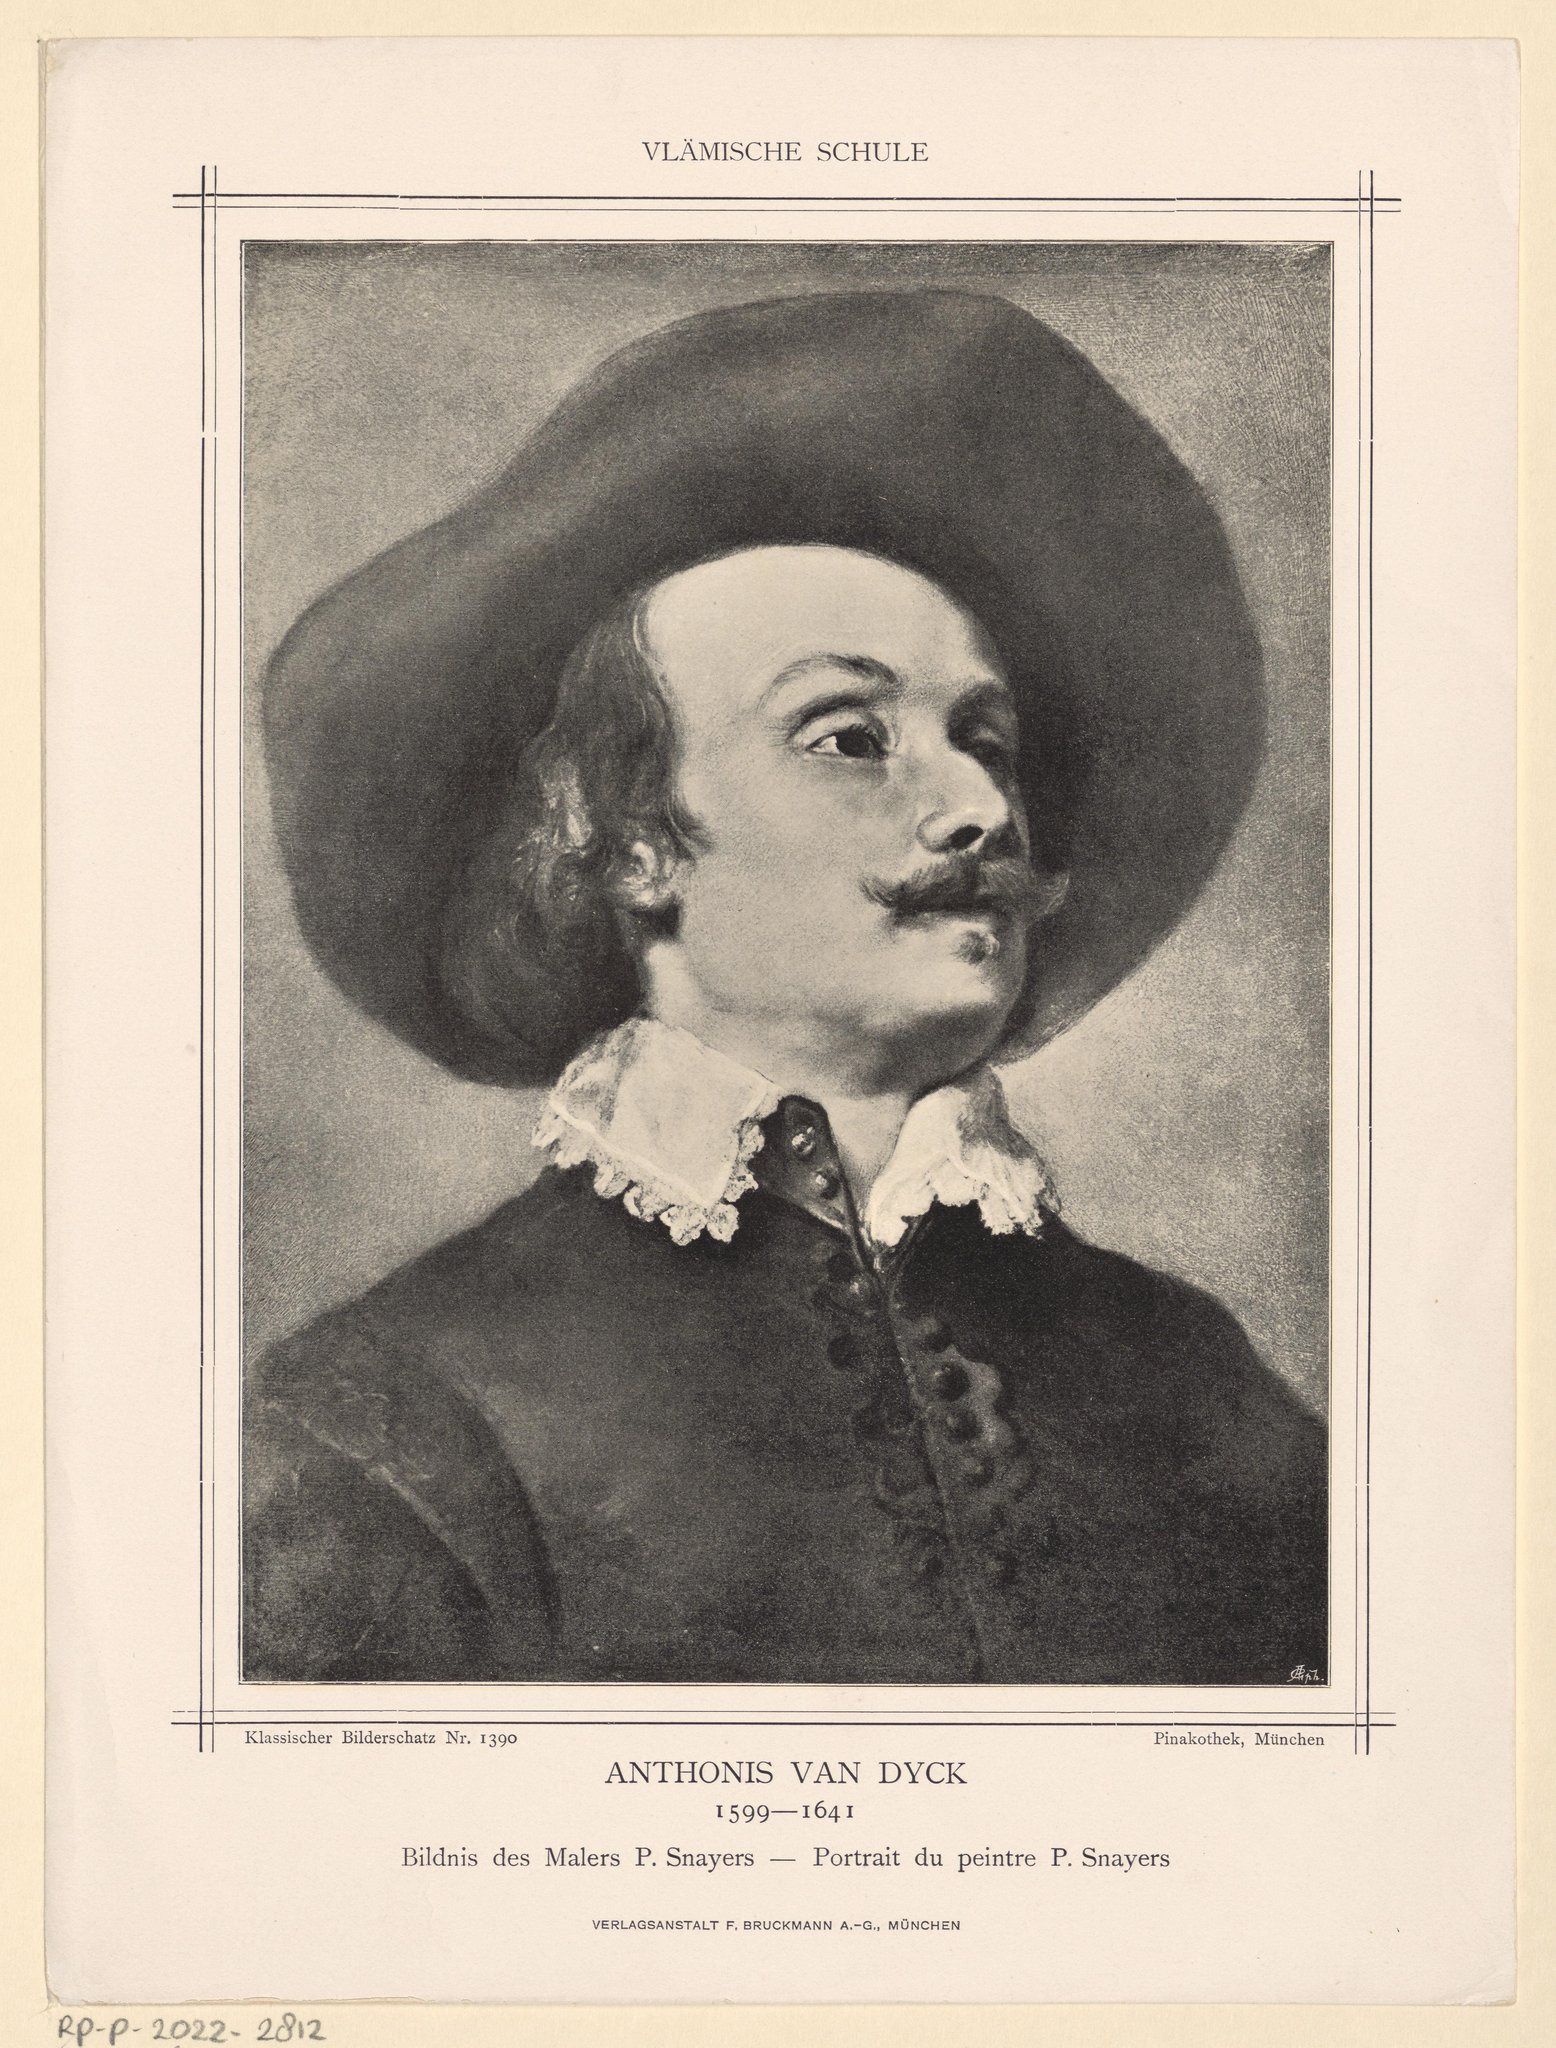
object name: photomechanical print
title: Portret van Peter Snayers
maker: anthony van dyck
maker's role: draughtsman, painter, print maker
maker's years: 1599-1641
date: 1866-1900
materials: paper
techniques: autotype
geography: munich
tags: antwerp, brussels, draughtsman, peeter snayers, historical persons, portrait, self-portrait of artist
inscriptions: collector's mark: Lugt 2228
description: Fotomechanische afdruk mogelijk uit een deel van: Reber, Franz von en Adolph Bayersdorfer. Klassischer Bilderschatz. München: Verlagsanstalt F. Bruckmann A.-G.